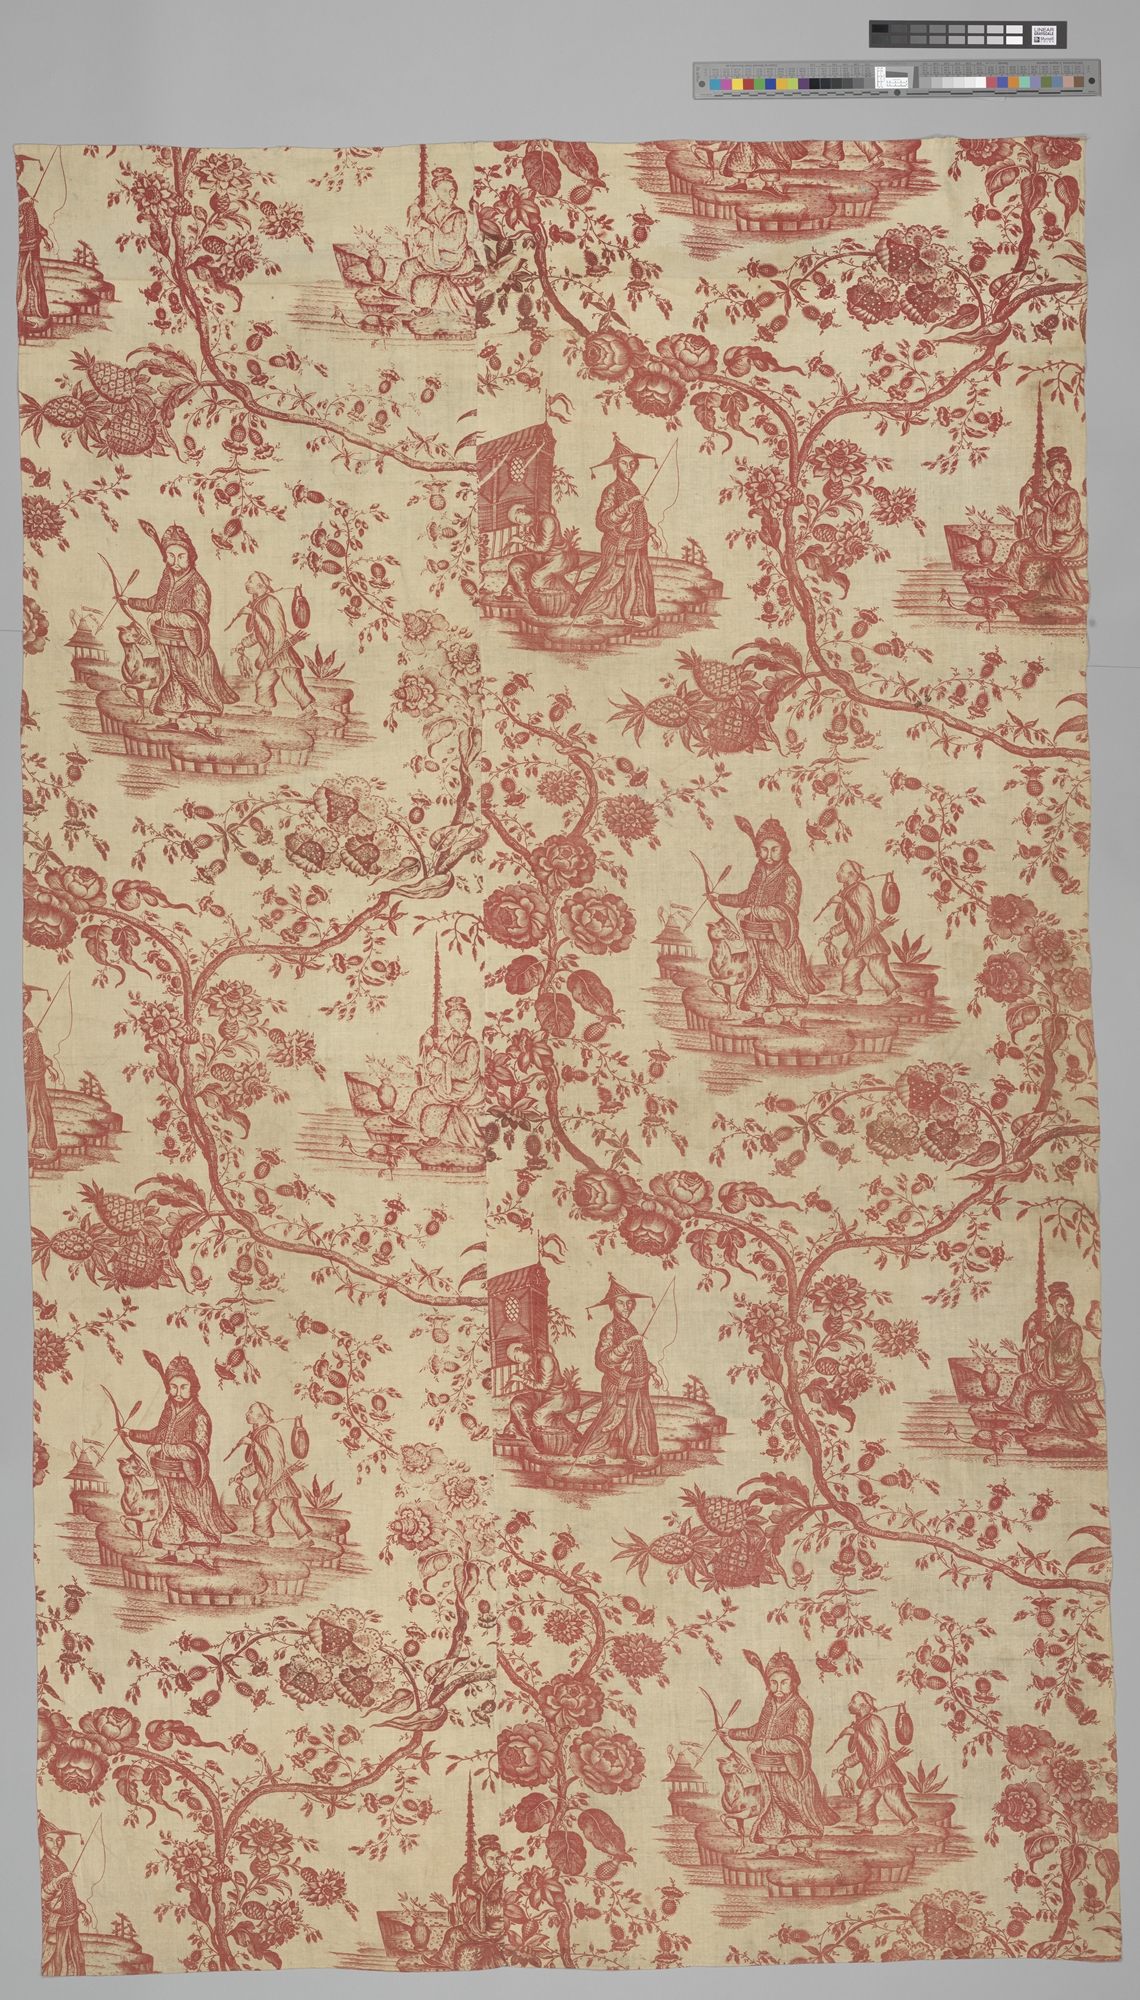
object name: hanging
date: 1780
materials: cotton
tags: chinoiserie,men,fishing,roses